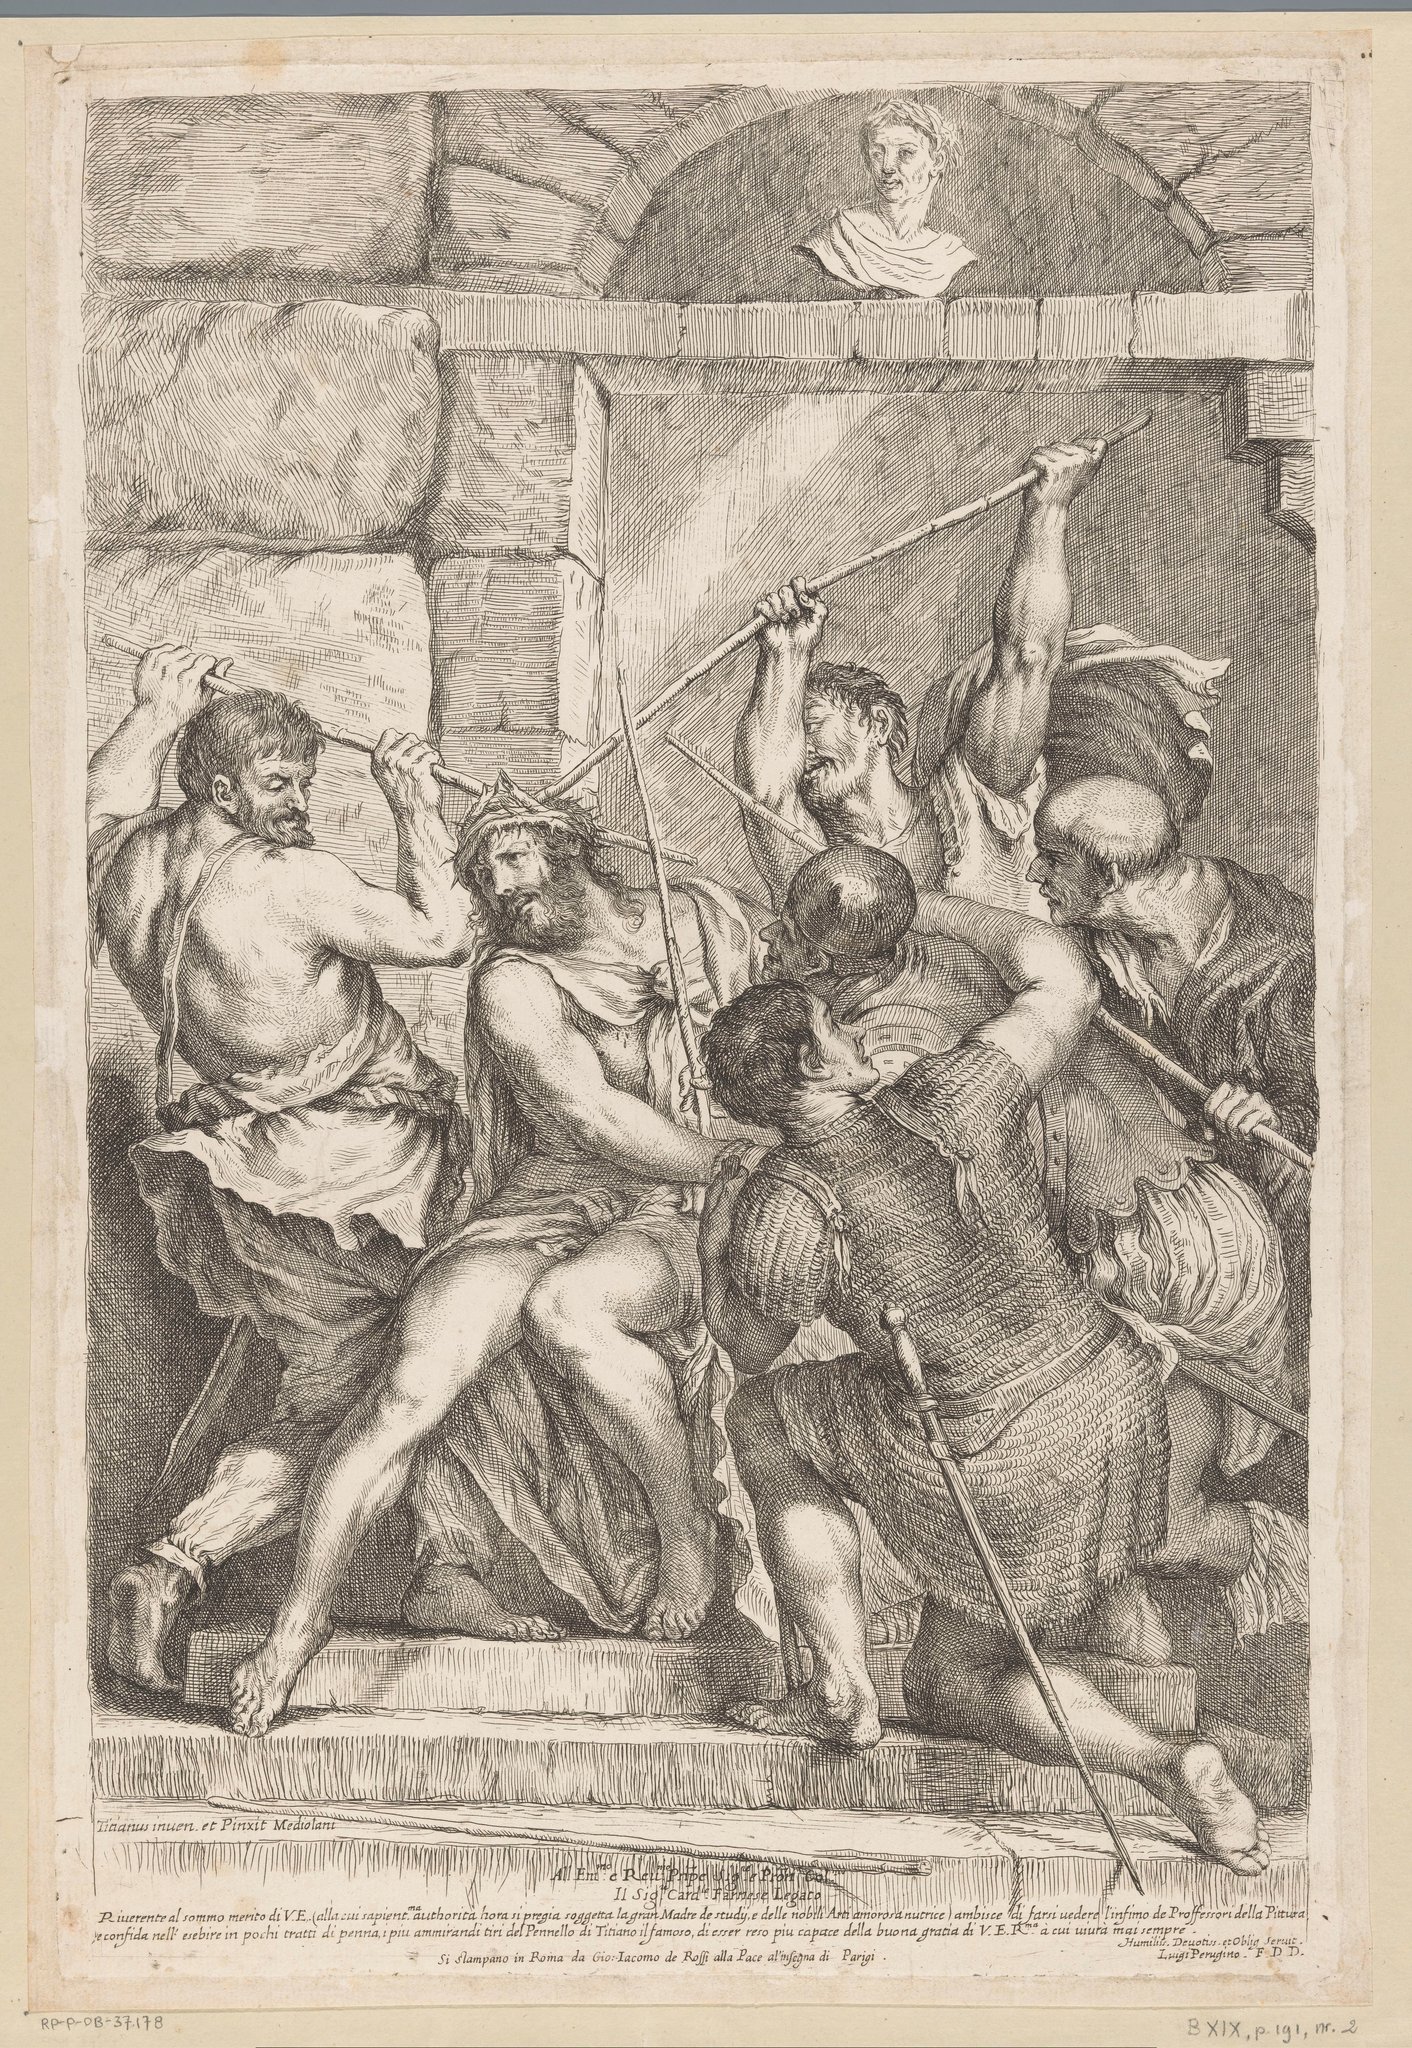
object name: print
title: Doornenkroning van Christus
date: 1626-1680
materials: paper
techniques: etching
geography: rome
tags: the crowning with thorns: soldiers with sticks place a thorny crown on christ's head and give him a reed (matthew 27:27-31; mark 15:16-20; john 19:2-3)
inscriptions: collector's mark: Lugt 240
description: Prent naar een schilderij gemaakt door Titiaan voor de Santa Maria delle Grazie te Milaan dat zich nu bevindt in het Musée du Louvre te Parijs.